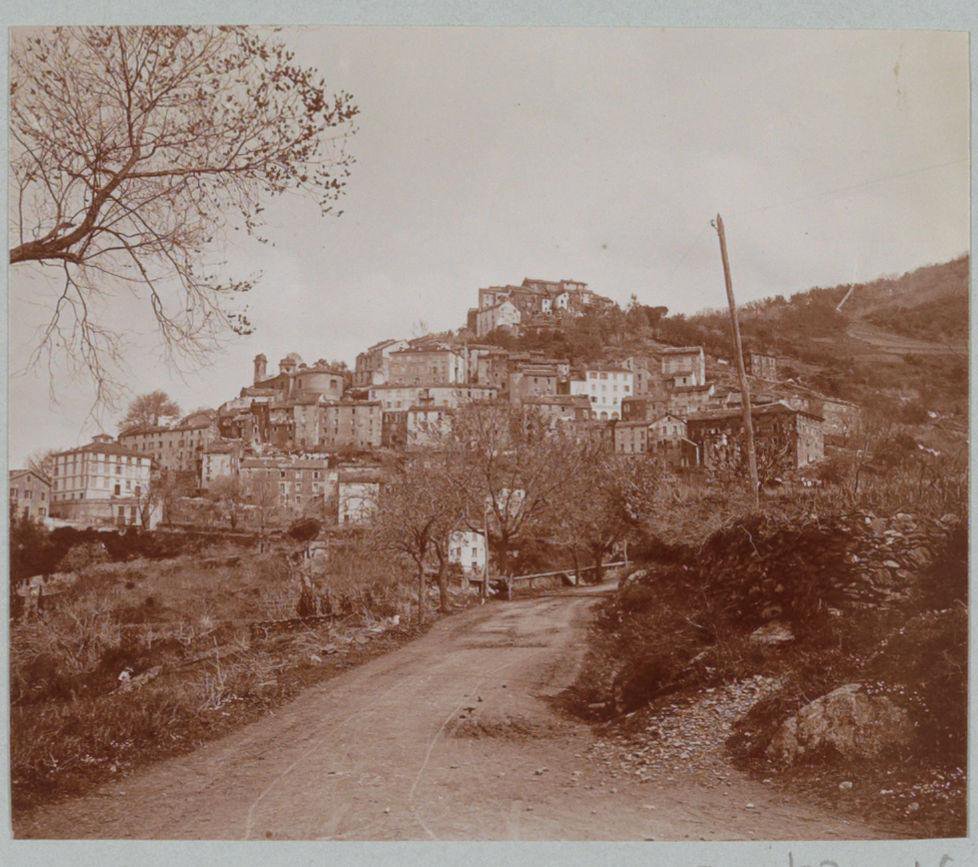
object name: photograph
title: Gezicht op een bergdorp, vermoedelijk op Corsica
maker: Anonymous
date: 1905-1910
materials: paper, photographic support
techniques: gelatin silver print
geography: corsica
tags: prospect of village, silhouette of village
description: Onderdeel van Fotoalbum van een Franse amateurfotograaf met bezienswaardigheden in Frankrijk, Zwitserland en Italië.